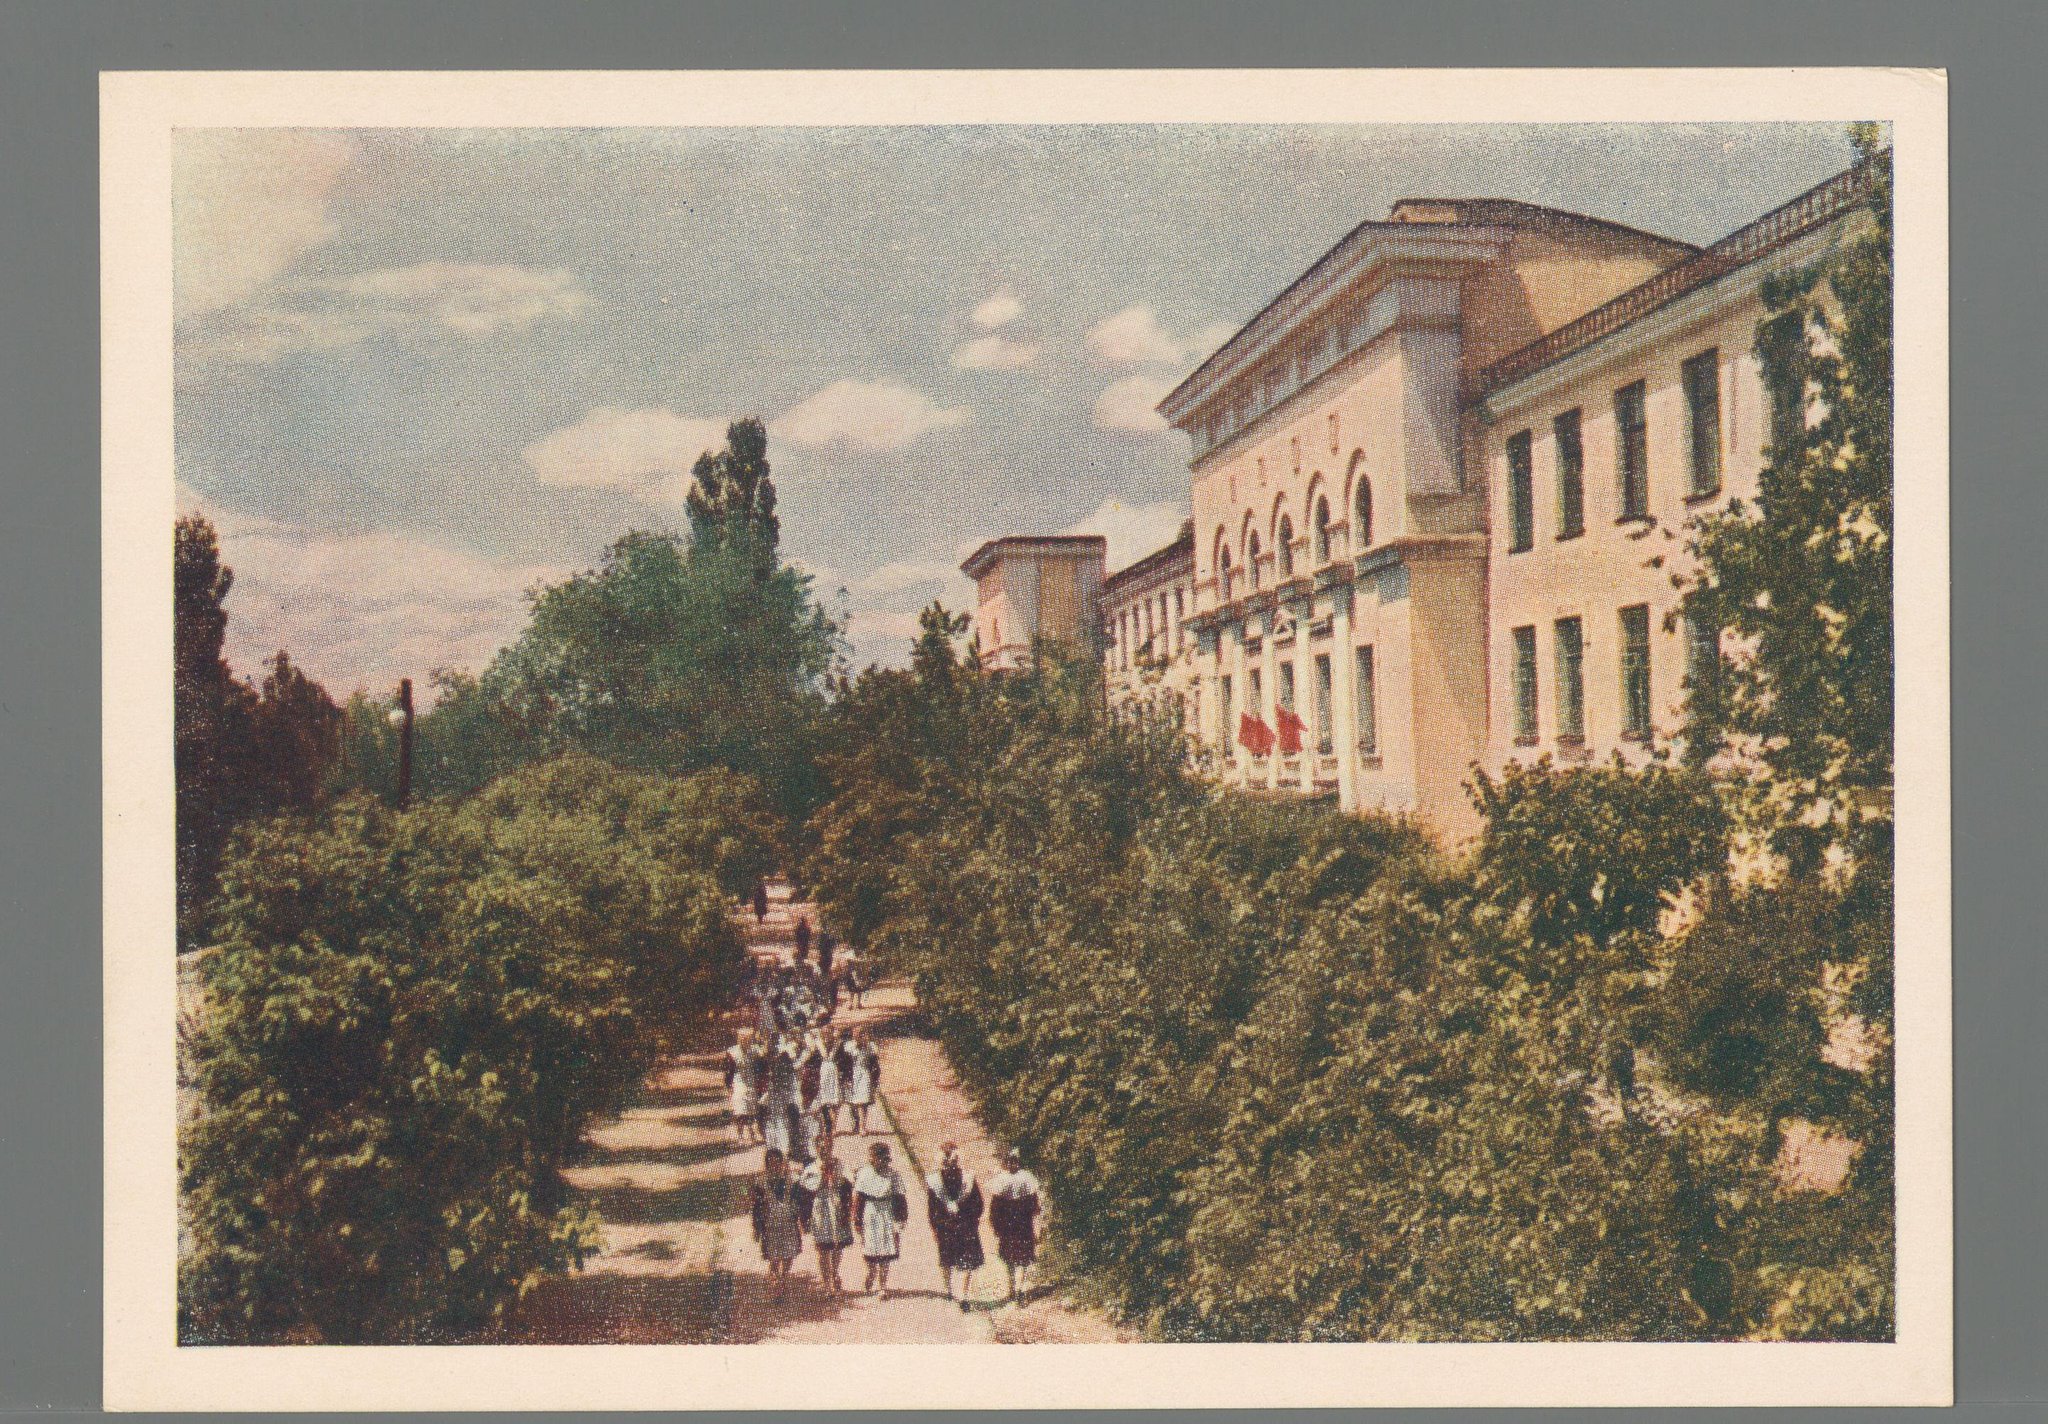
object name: ansichtkaart, prentbriefkaart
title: Kazakh S.S.R. Alma-Ata. Secondary School No. 54 / R.S.S. de Kazakhie. Alma-Ata. Ecole secondaire no 54 / Kasachische SSR. Alma-Ata. Mittelschule Nr. 54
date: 1956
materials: cardboard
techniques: color autotype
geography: moscow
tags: secondary education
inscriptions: date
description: De titel op object staat ook in het Russisch.